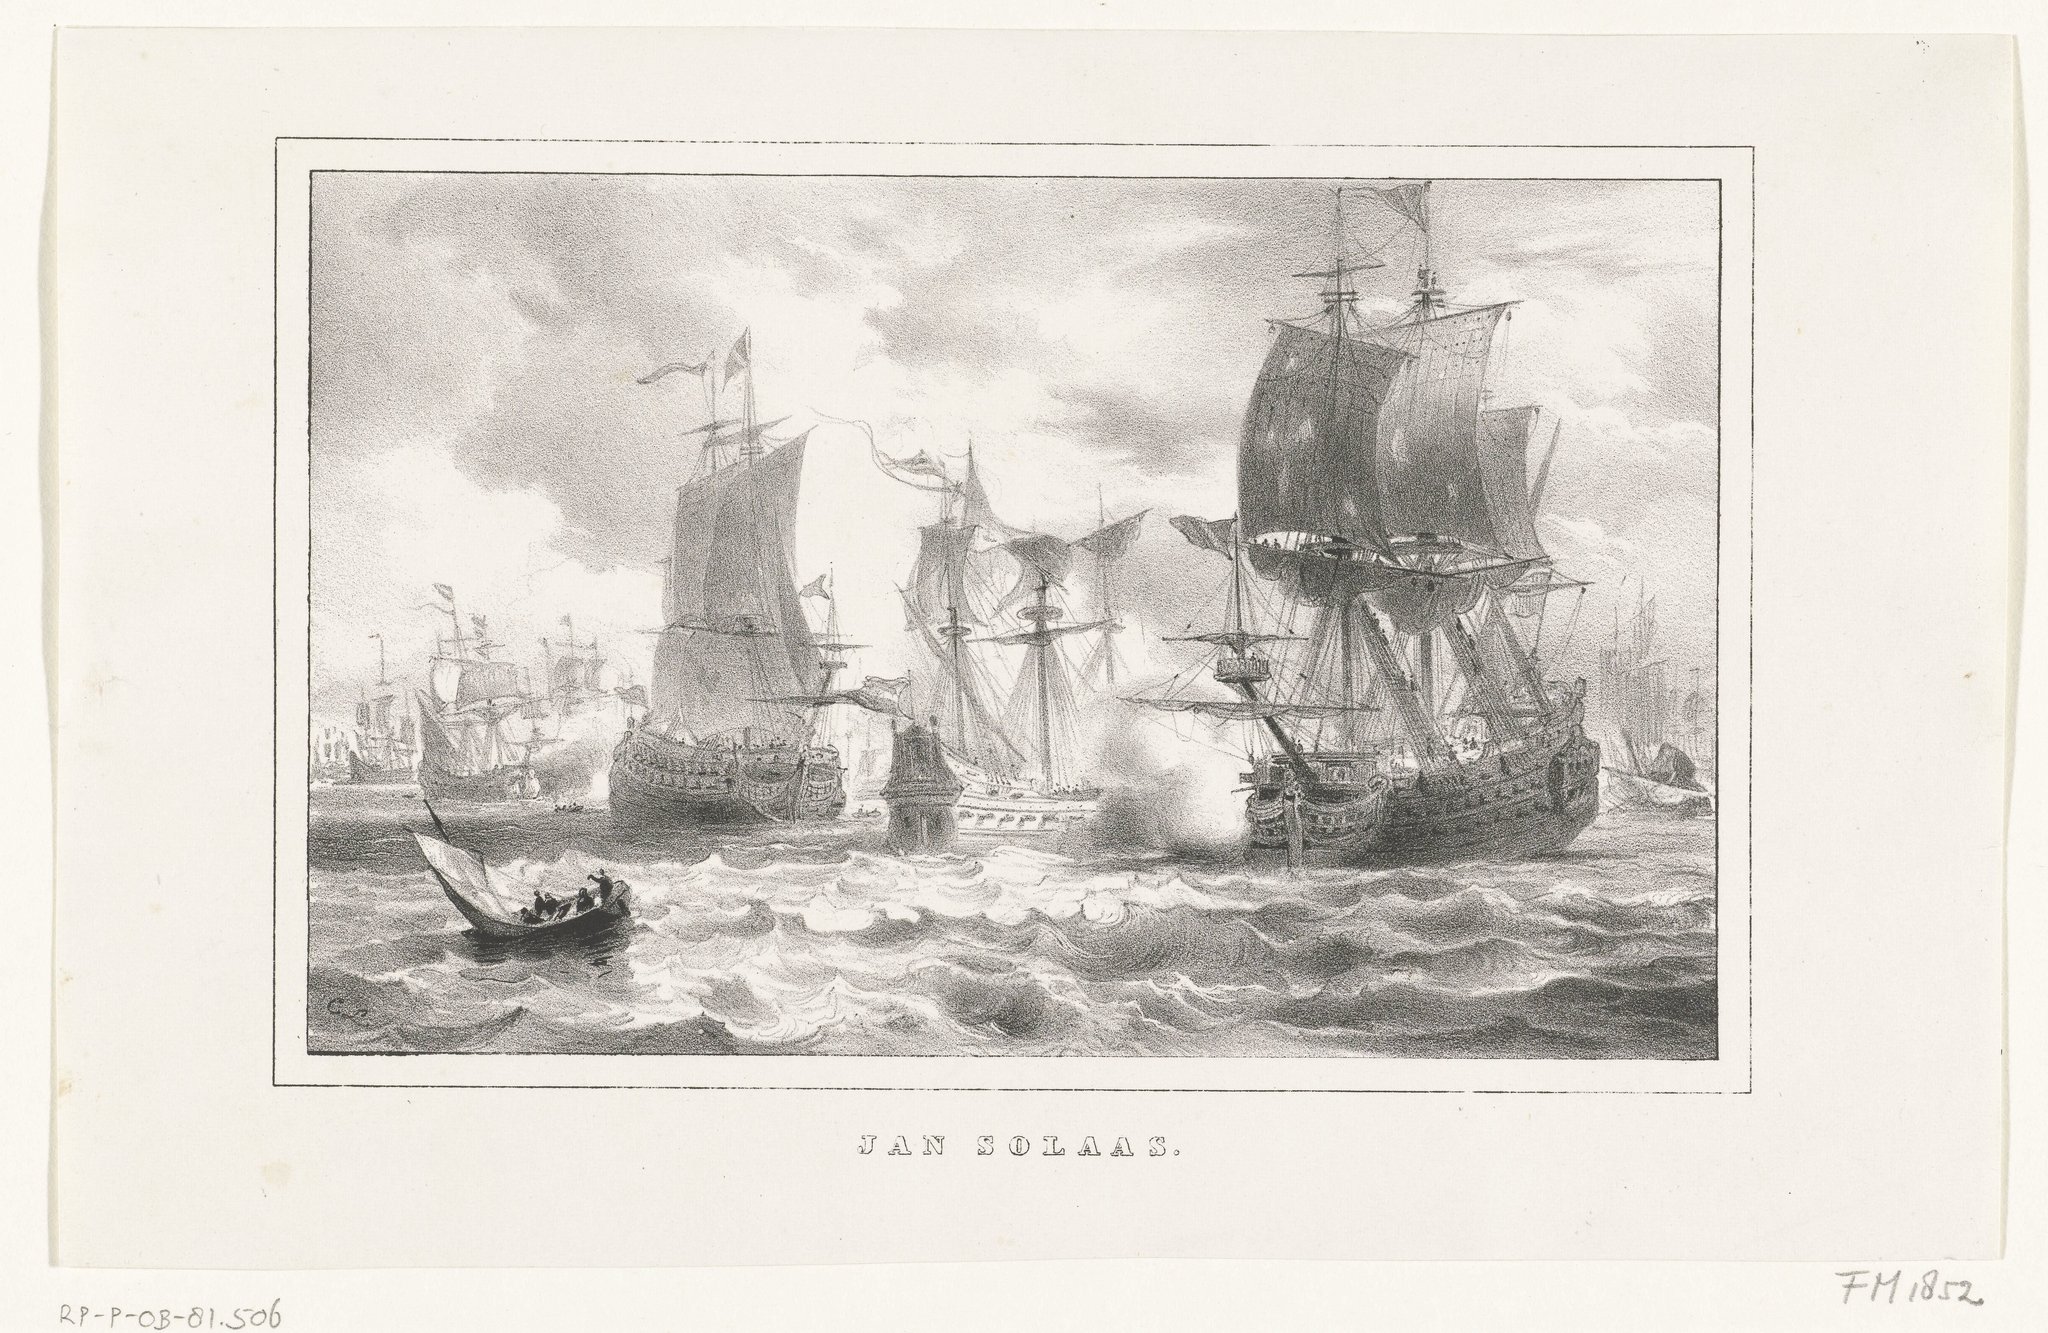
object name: history print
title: Kapitein Jan Solaas wordt tijdens de slag bij Kaap St. Vincent door de Ruyter ontzet, 1641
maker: carel christiaan antony last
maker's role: print maker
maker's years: 1808-1876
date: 1850-1852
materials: paper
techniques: lithograph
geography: netherlands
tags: flushing, michiel adriaenszoon de ruyter, battle (+ naval force)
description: Kapitein Jan Solaas op het schip de Engel Gabriel wordt tijdens de slag bij Kaap St. Vincent door twee Spaanse schepen aangevallen maar door Michiel Adriaenszoon de Ruyter ontzet, 4 november 1641.